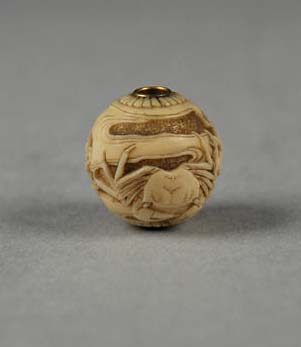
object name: bead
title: Carved Bead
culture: japanese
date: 1801-1900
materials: ivory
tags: crabs